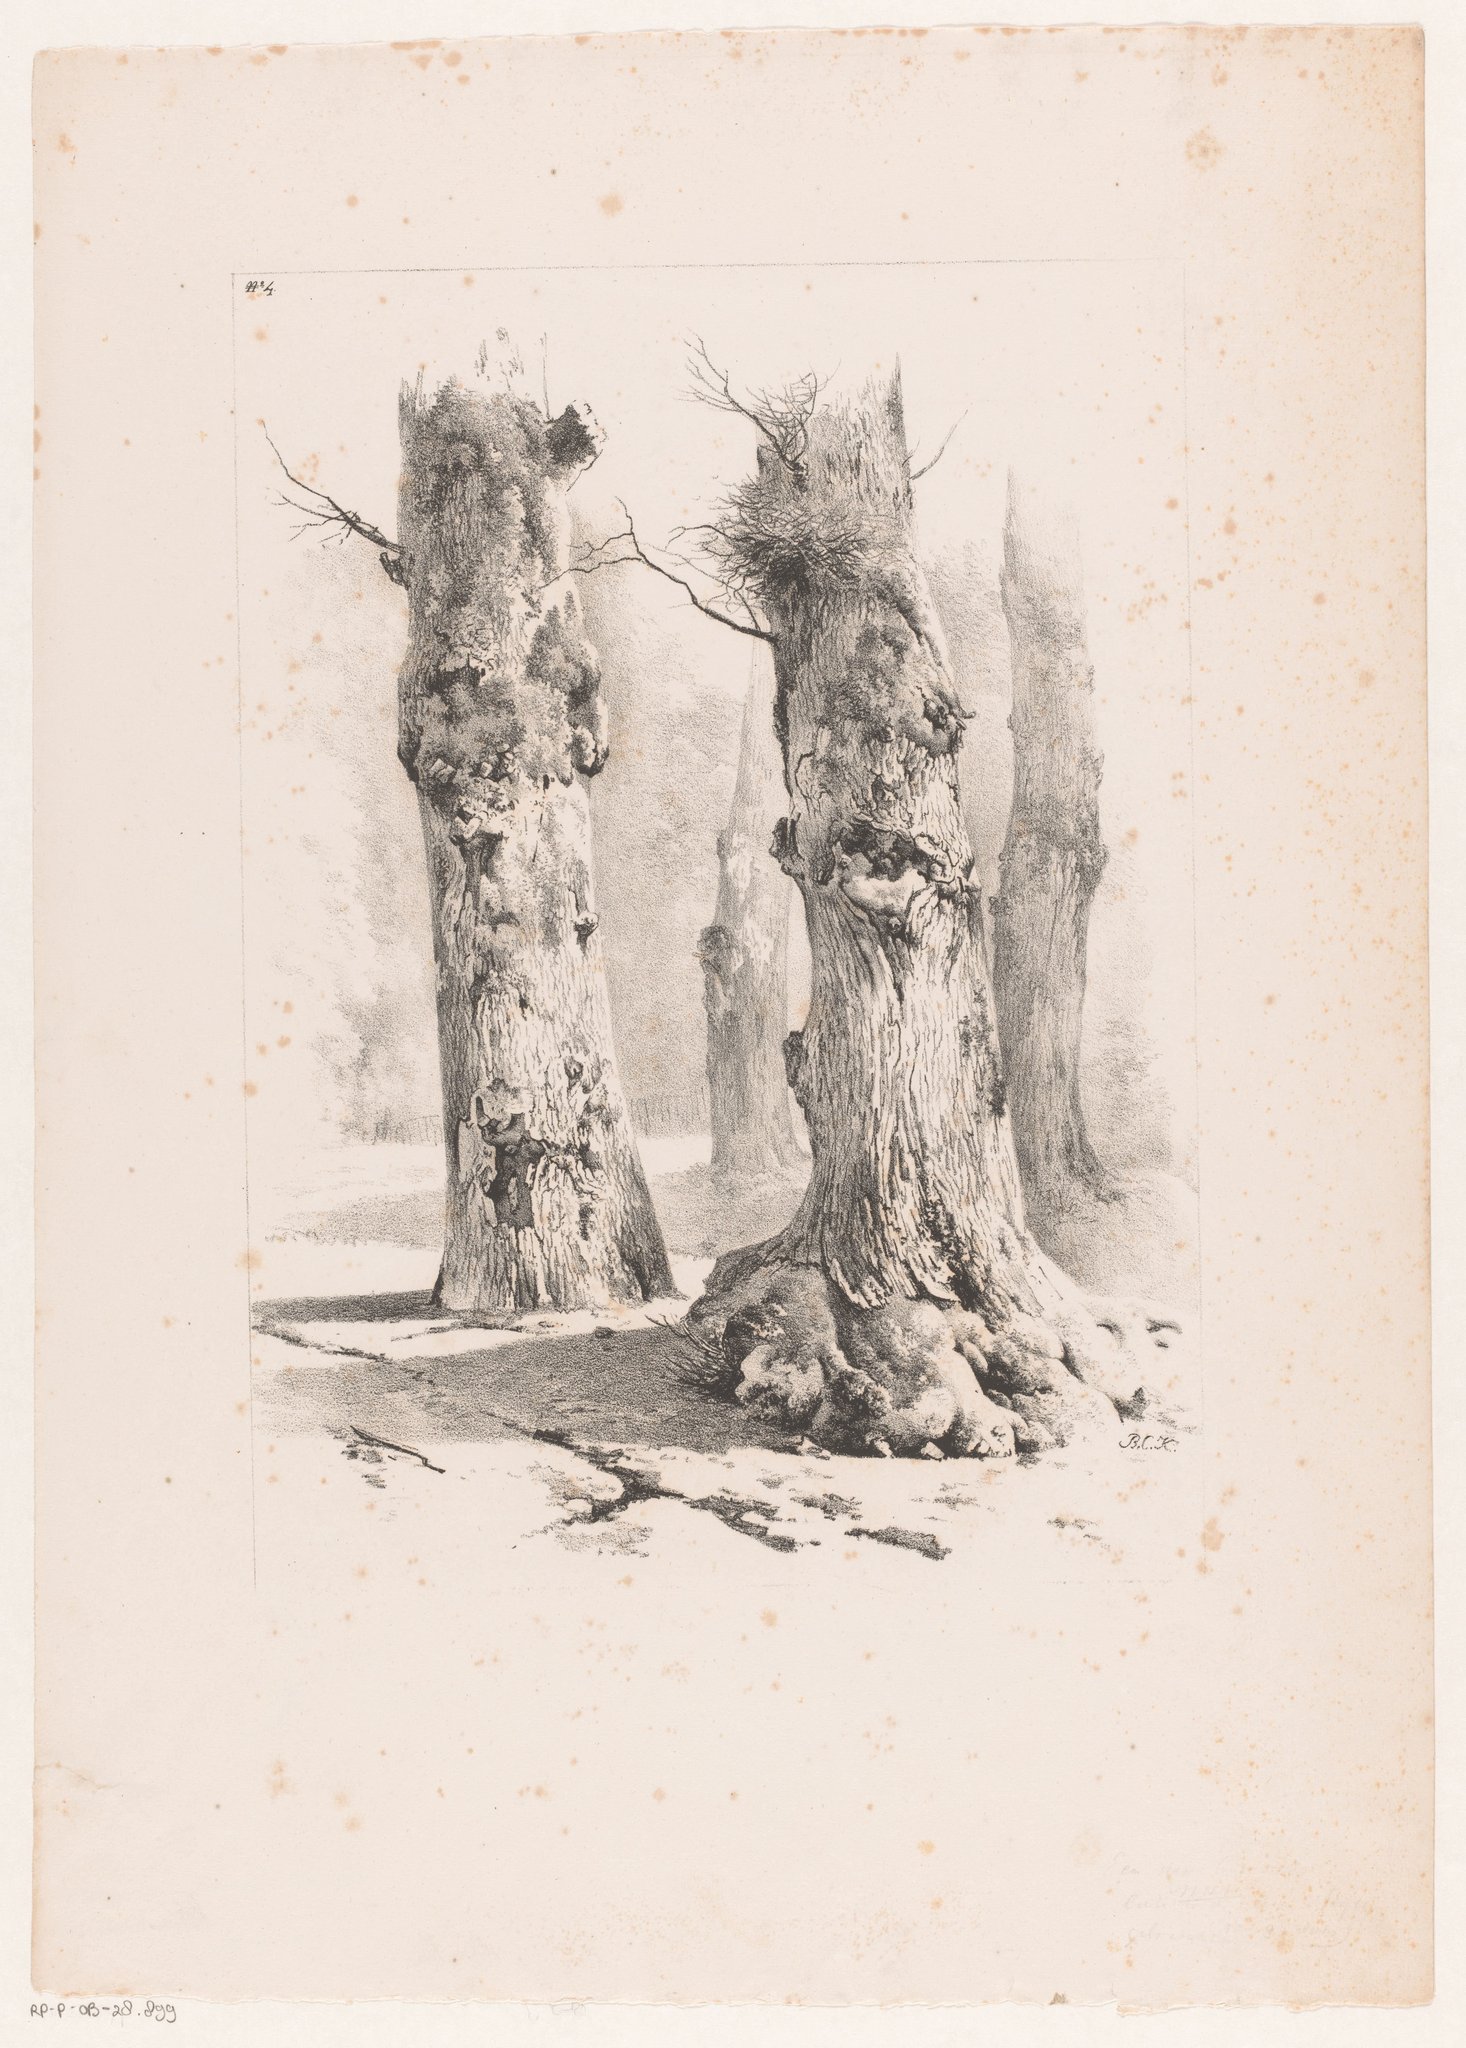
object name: print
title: Landschap studiën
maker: barend cornelis koekkoek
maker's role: draughtsman, painter, print maker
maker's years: 1803-1862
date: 1829-1830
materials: paper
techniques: lithograph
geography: amsterdam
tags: forest, wood, groups of trees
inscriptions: collector's mark: Lugt 2228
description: In 1829 en 1830 gaf Koekkoek, samen met Daiwaille, zes cahiers uit met ieder zes prenten getiteld Landschapstudiën. Deze werden gebruikt in het tekenonderwijs. Vijftien jaar later werd deze reeks, in een andere samenstelling nogmaals uitgegeven door Meyer en Comp in Amsterdam. Zie: De Bruyn Kops, 1963 en Nollert, 1997.